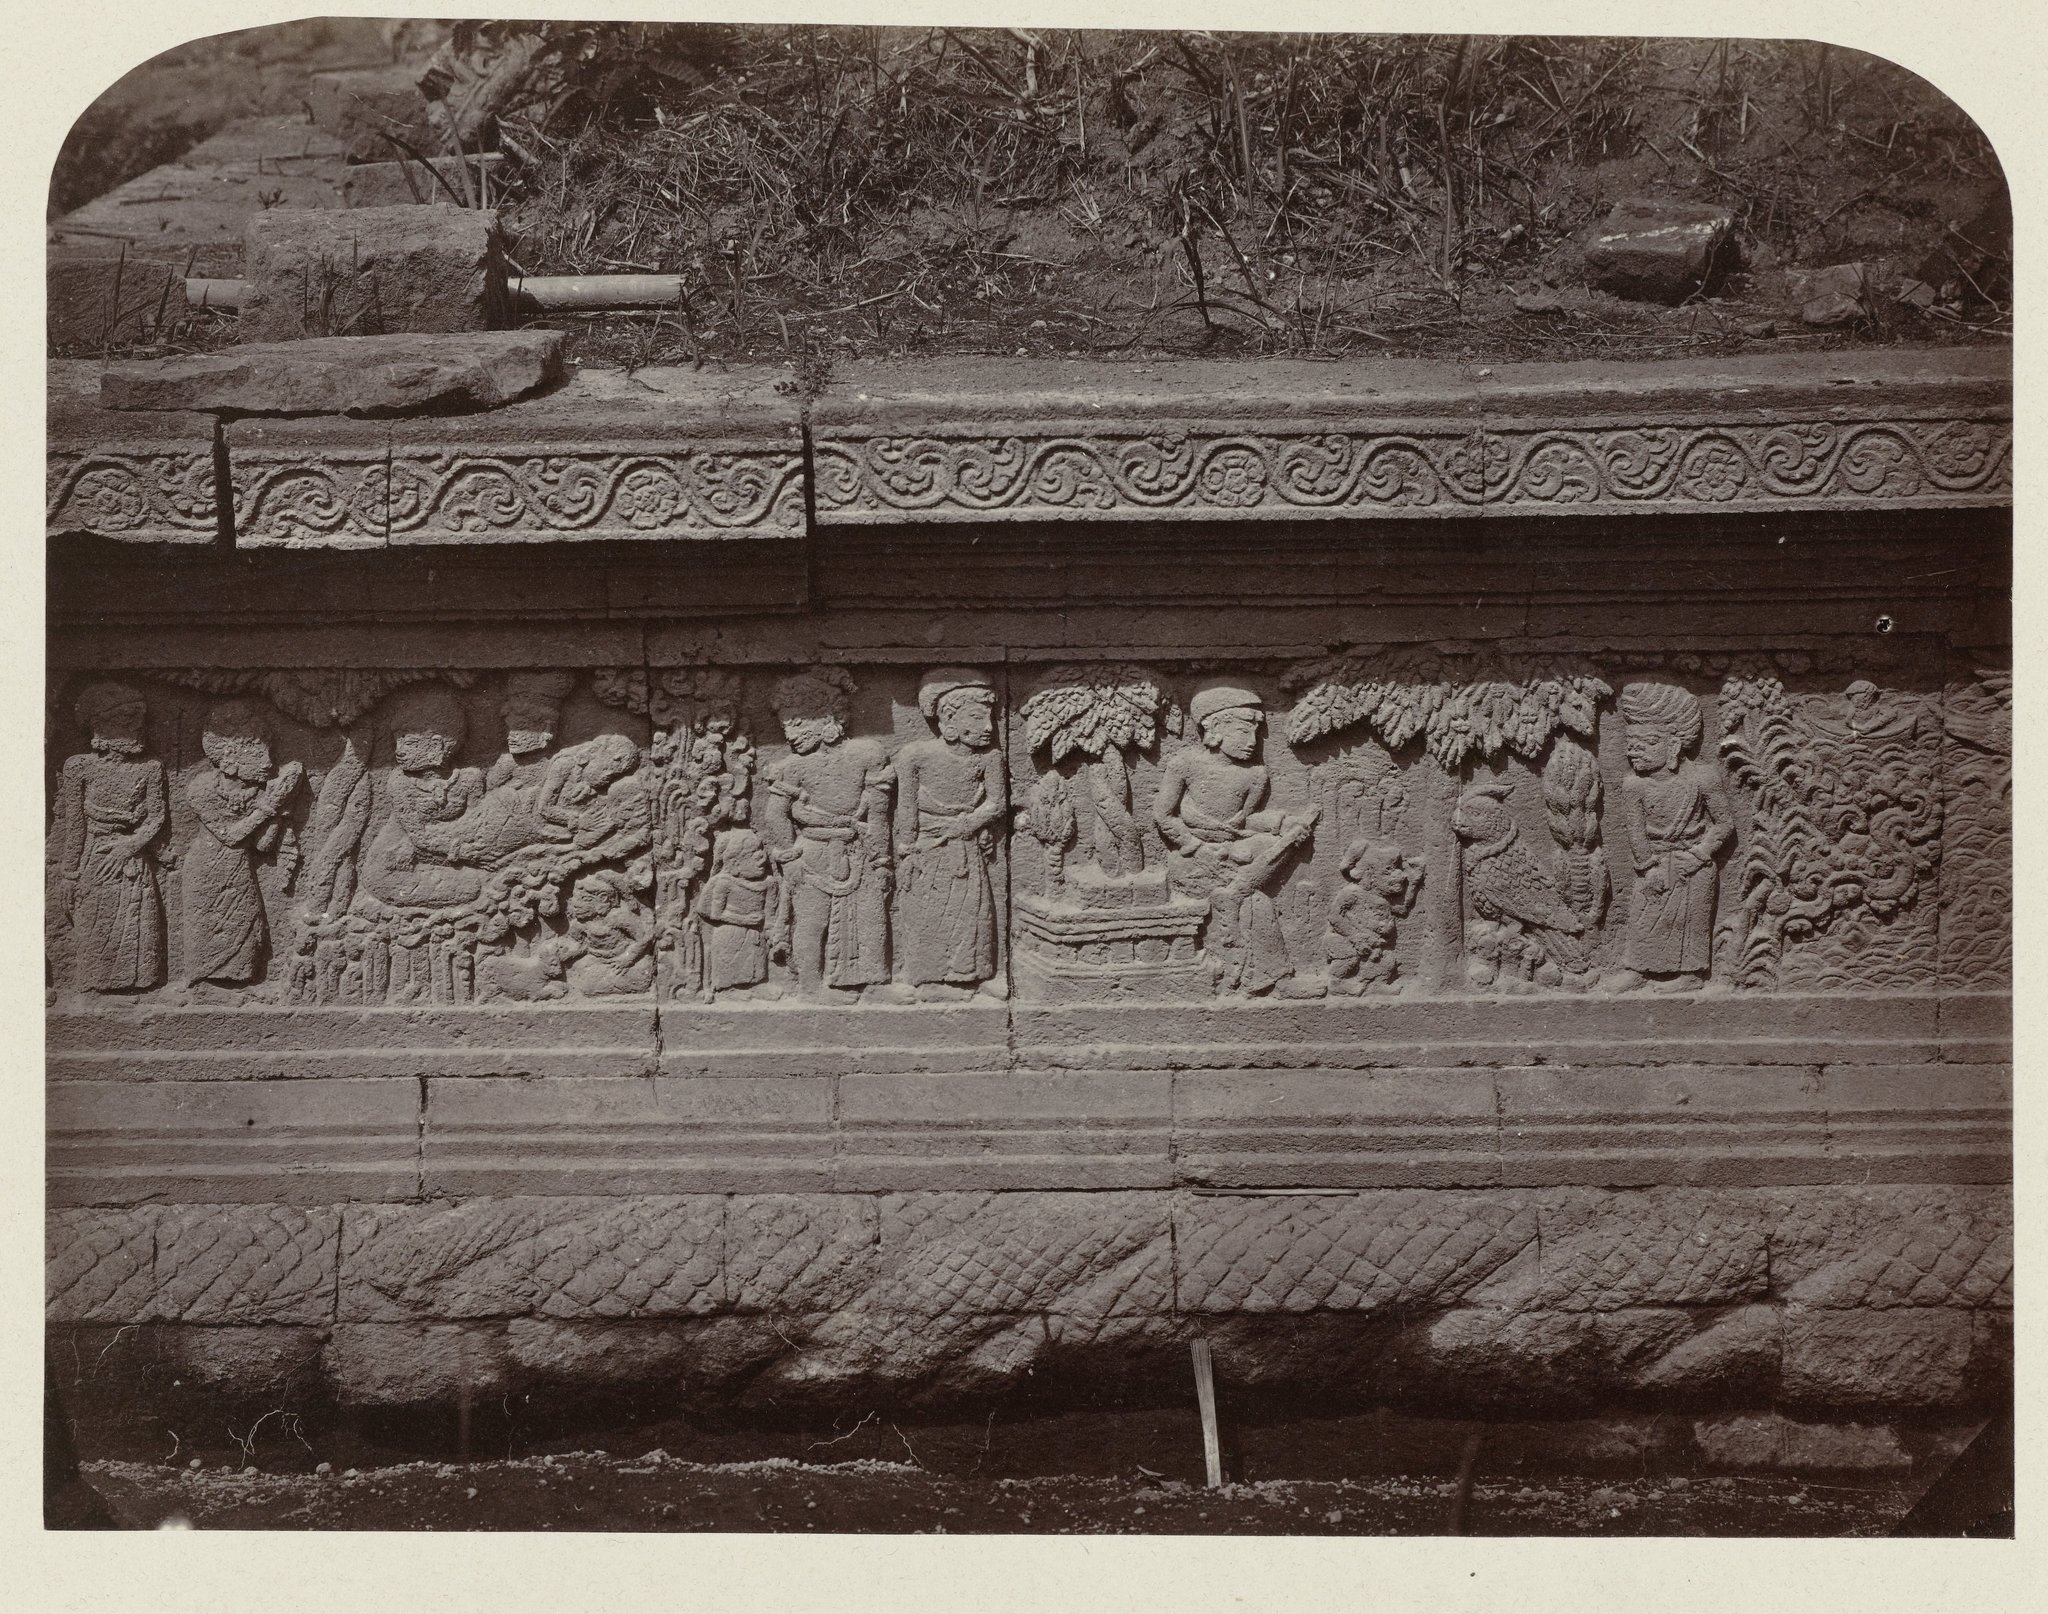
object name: photograph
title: Basrelief op het voetstuk eener pendopo (?) (westzijde). Panataran (r. Kediri)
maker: isidore kinsbergen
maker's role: fotograaf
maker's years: 1821-1905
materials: cardboard, paper, photographic support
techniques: albumen print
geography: java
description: Candi Panataran (Temple Complex), Pendopo Terrace, unidentified reliefs 47-50 (inscription above no. 50 reads jarumanatat; 'Parrot' story), west side. Panataran, Blitar district, East Java province, 1375 AD